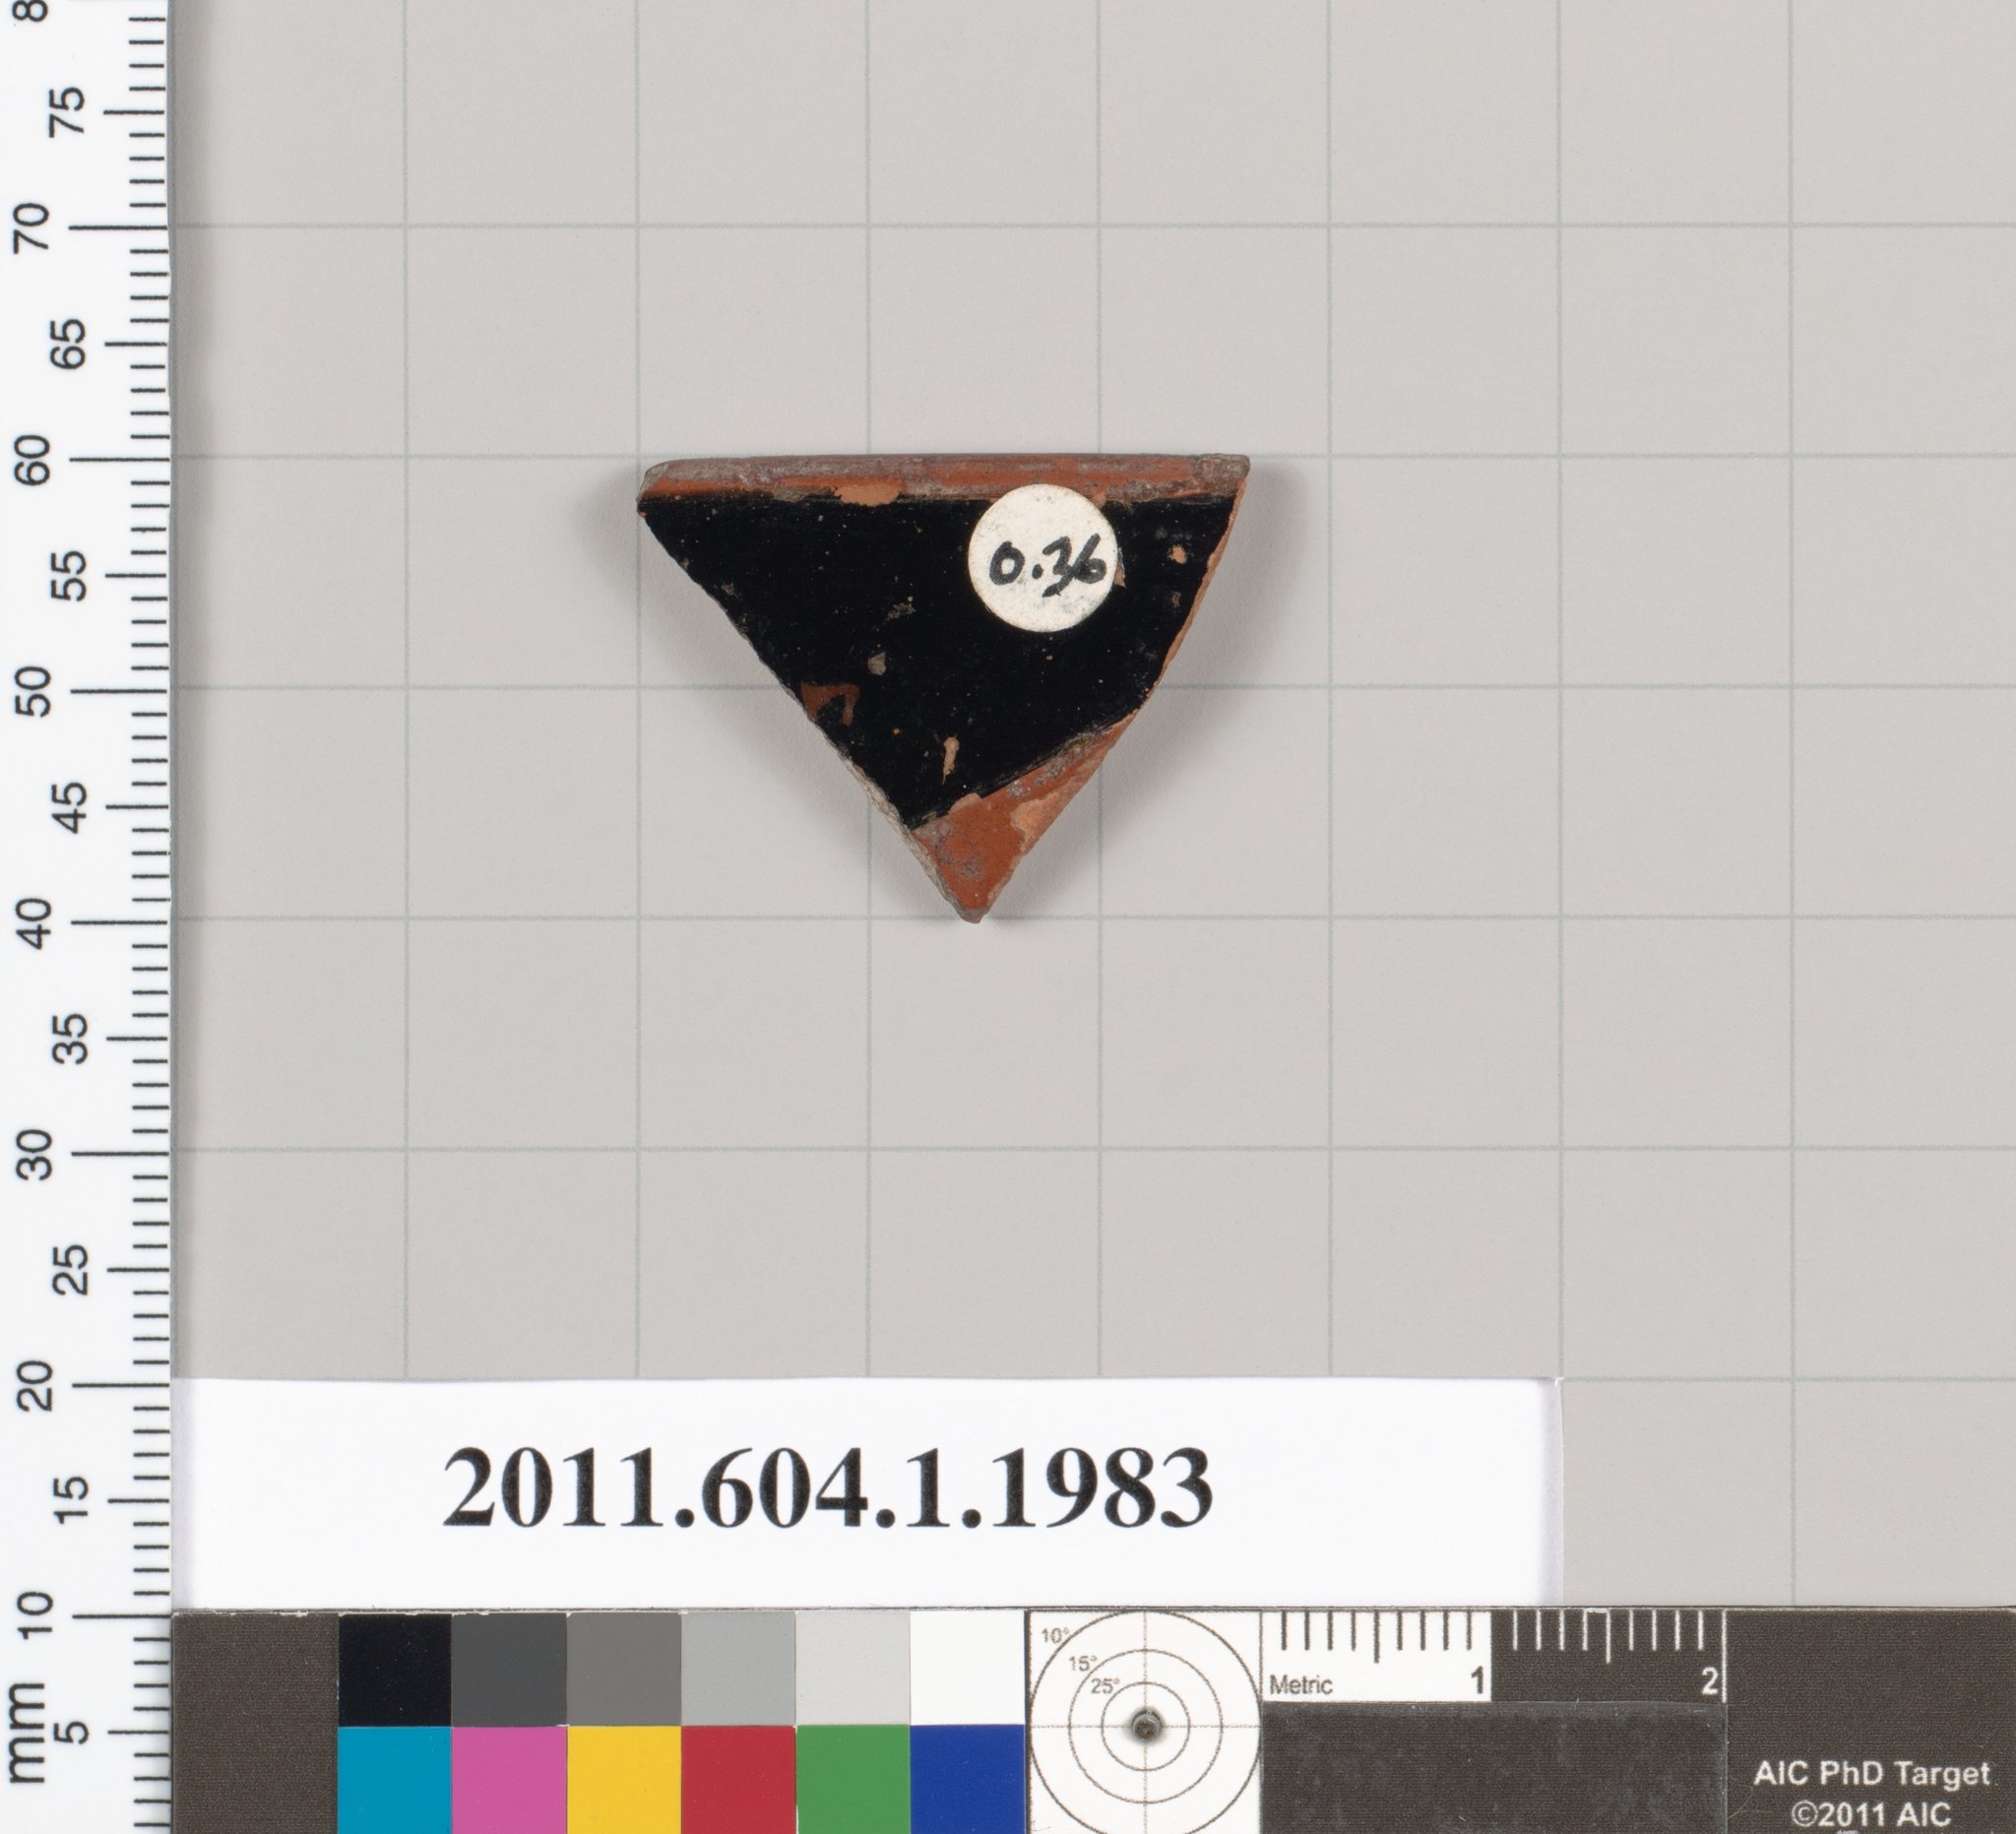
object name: kylix fragment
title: Terracotta rim fragment of a kylix (drinking cup)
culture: greek, attic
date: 500-401 BCE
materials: terracotta